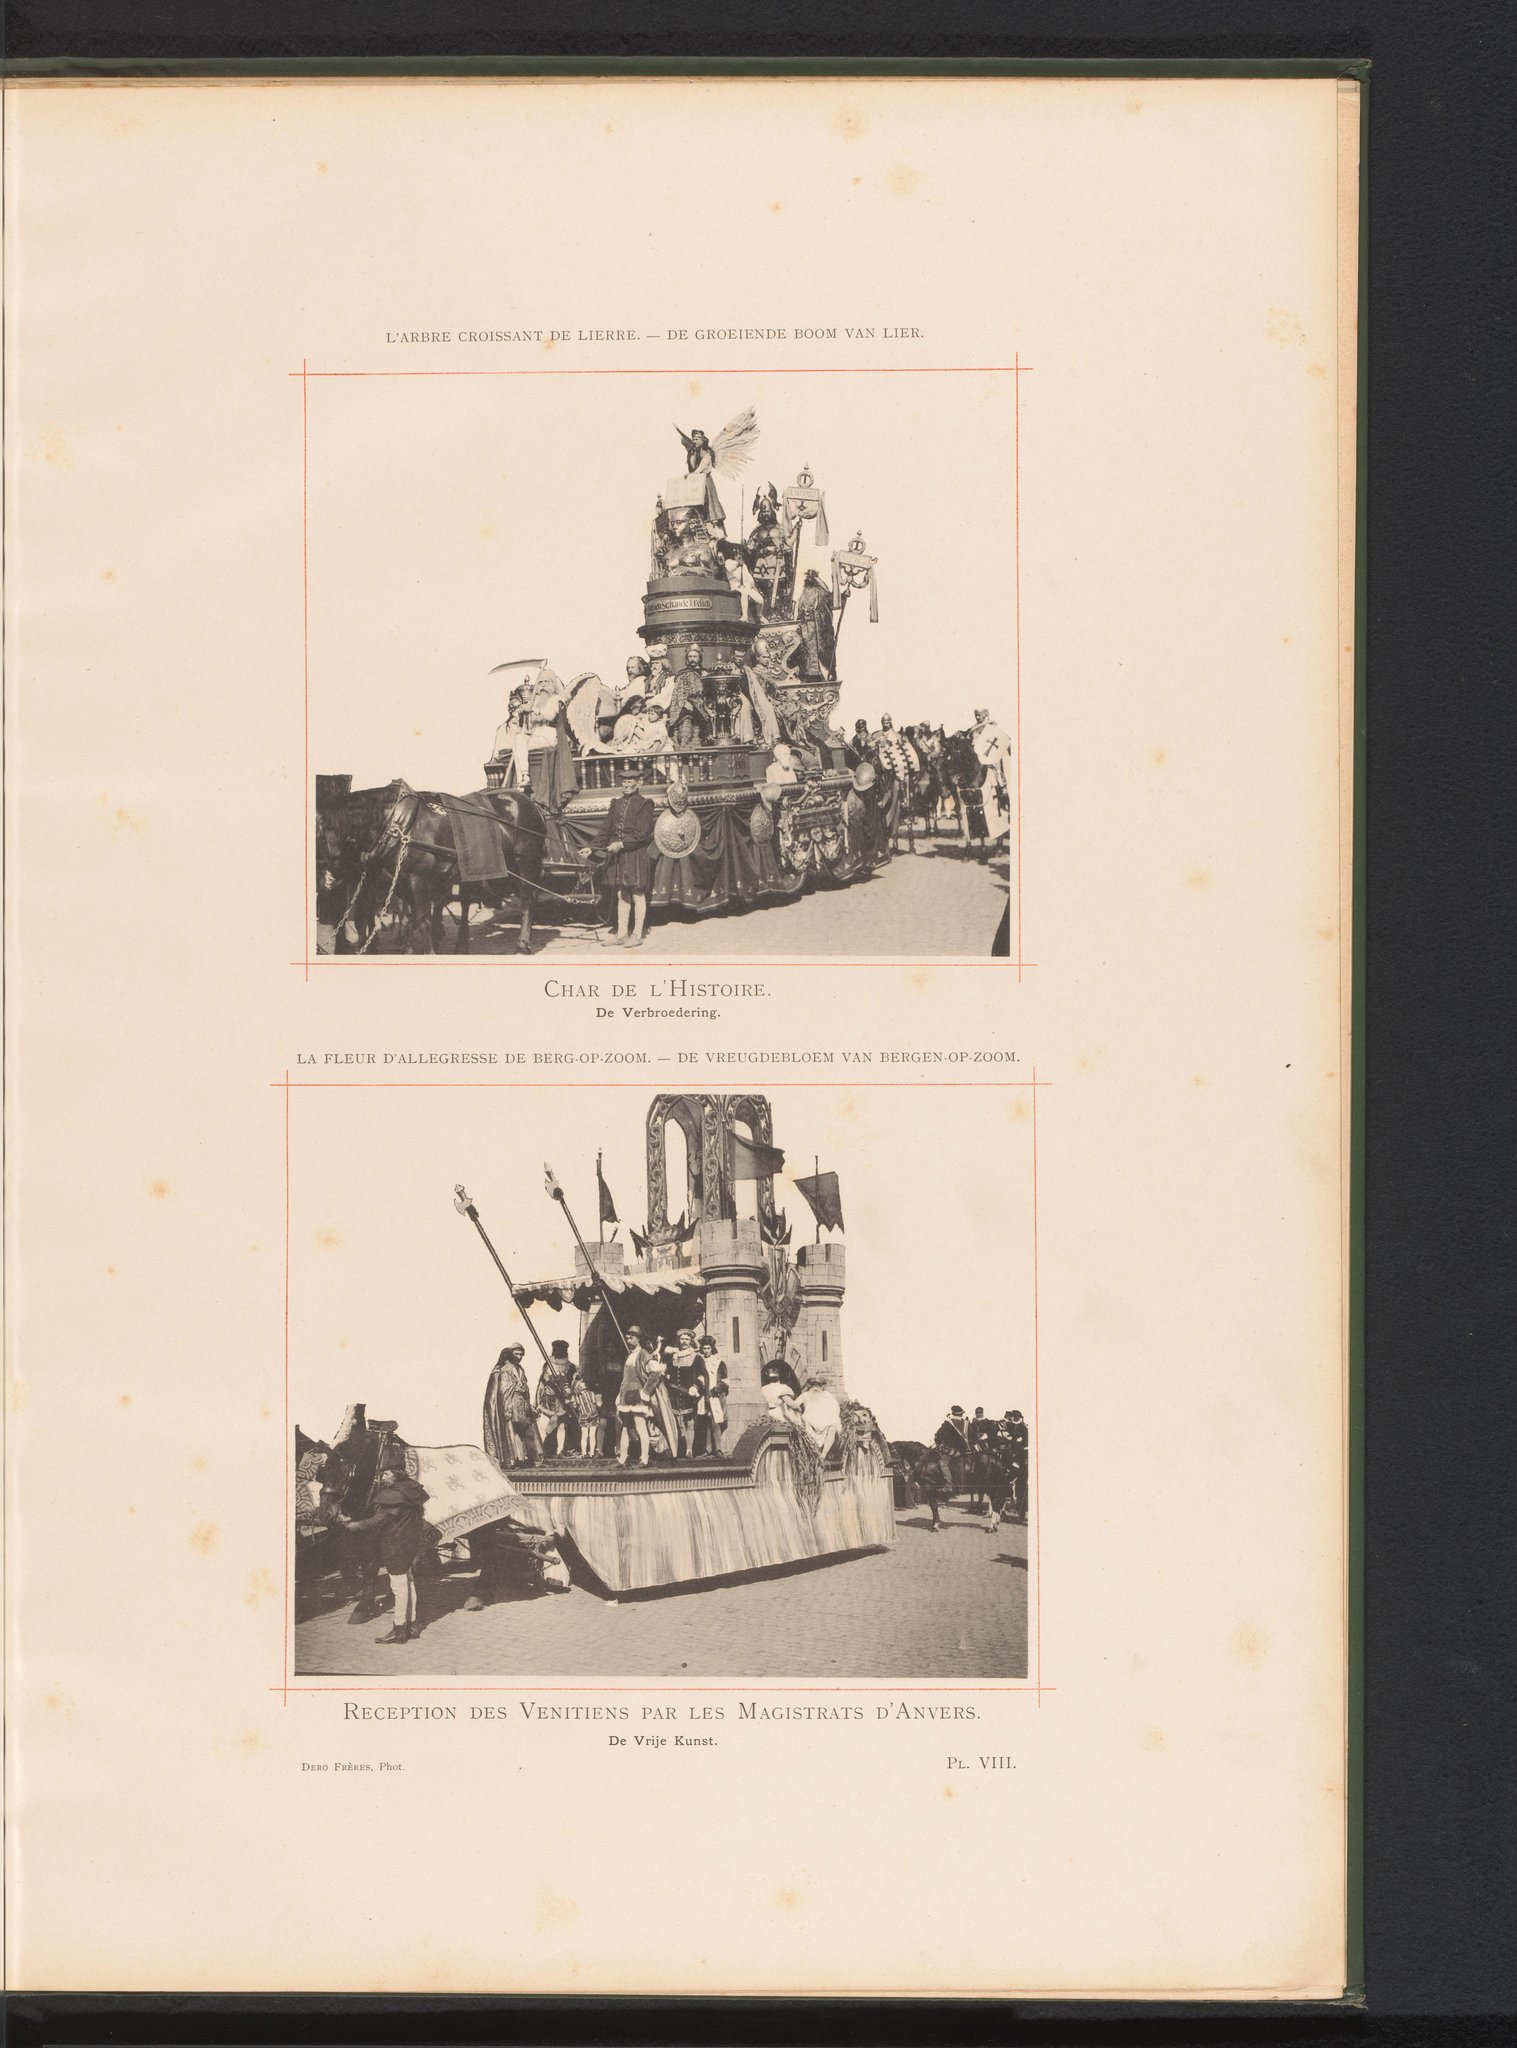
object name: page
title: Reception des Venetiens par les Magistrats d'Anvers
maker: joseph maes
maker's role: fotograaf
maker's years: 1838-1908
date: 1892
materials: paper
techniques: photograph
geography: antwerp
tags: public festivities (+ parade, pageant, cavalcade ~ festive activities), antwerp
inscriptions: inscription: ‘De Vrije Kunst.’, inscription: ‘De Verbroedering.’, inscription: ‘L'ARBRE CROISSANT DE LIERRE. - DE GROEIENDE BOOM VAN LIER.’, number: ‘Pl. VIII.’, inscription: ‘LA FLEUR D'ALLEGRESSE DE BERG-OP-ZOOM. - DE VREUGDEBLOEM VAN BERGEN-OP-ZOOM.’